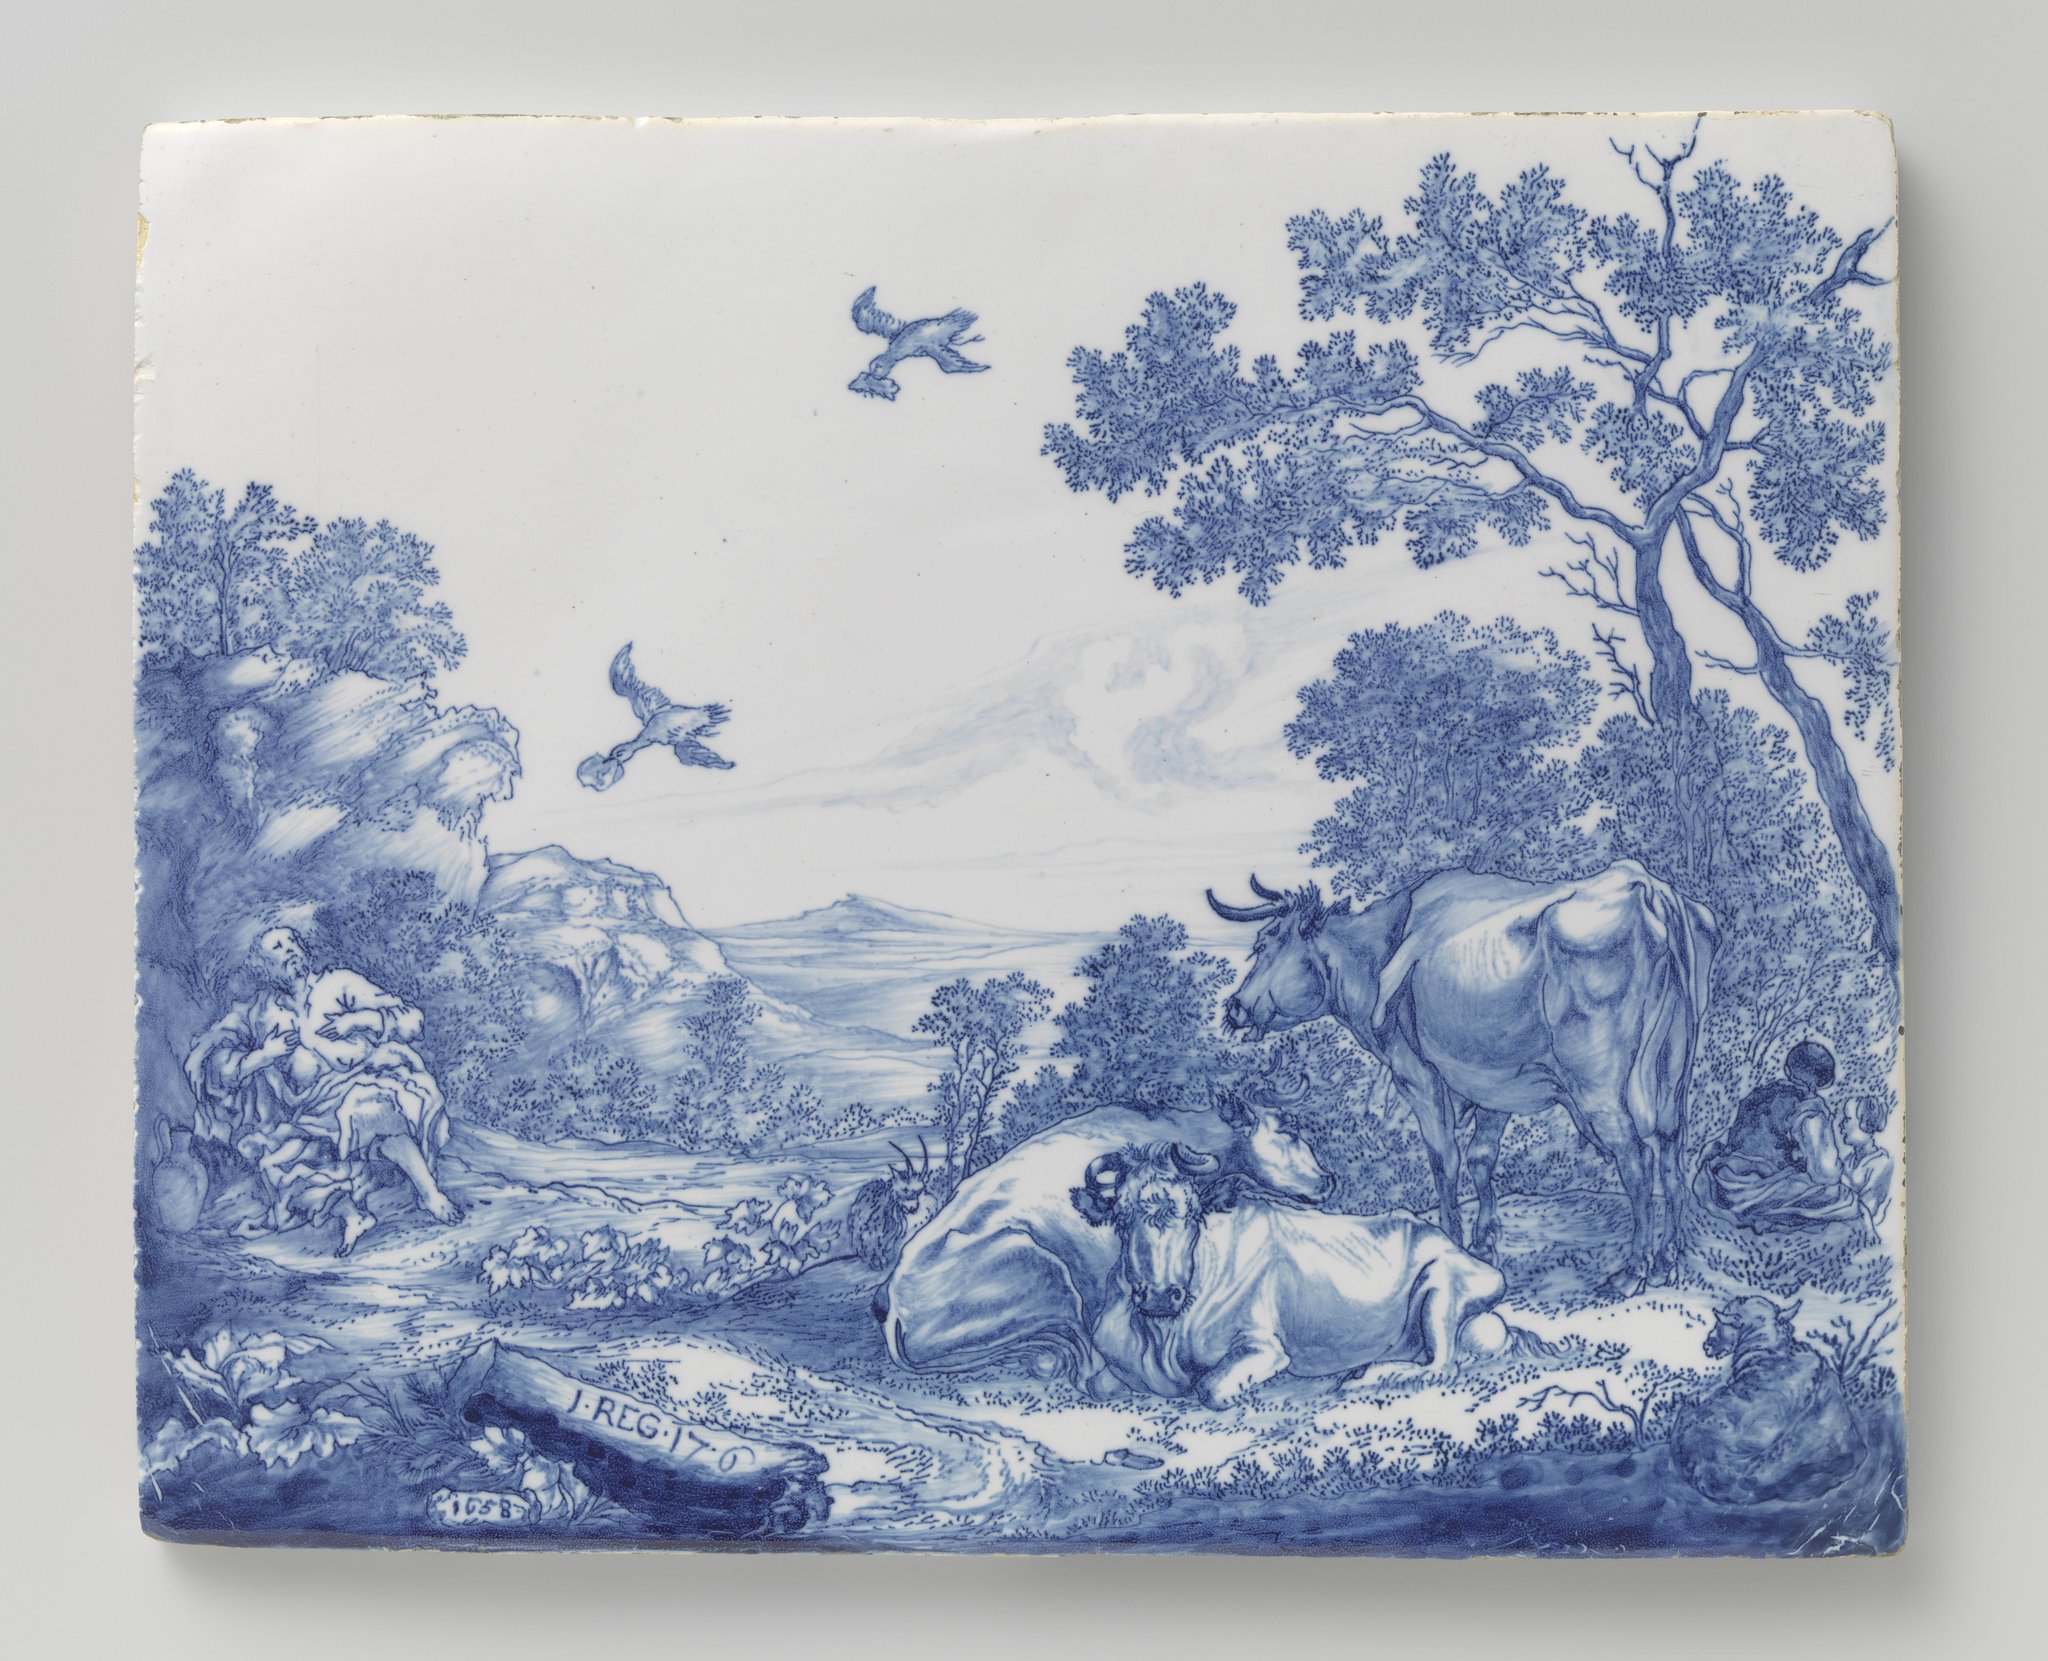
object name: plate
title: Plaque with Elijah Fed by Ravens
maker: Anonymous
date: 1658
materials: earthenware, glaze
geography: delft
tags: cow, elijah fed by the raven(s): while the prophet is living by the brook, ravens bring him food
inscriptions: date: ‘1658’, date: ‘1658’, inscription: ‘I reg 17.6’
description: Plaat van faïence, in blauw beschilderd met een voorstelling van de profeet Elia door de raven gevoed, met jaartal 1658.